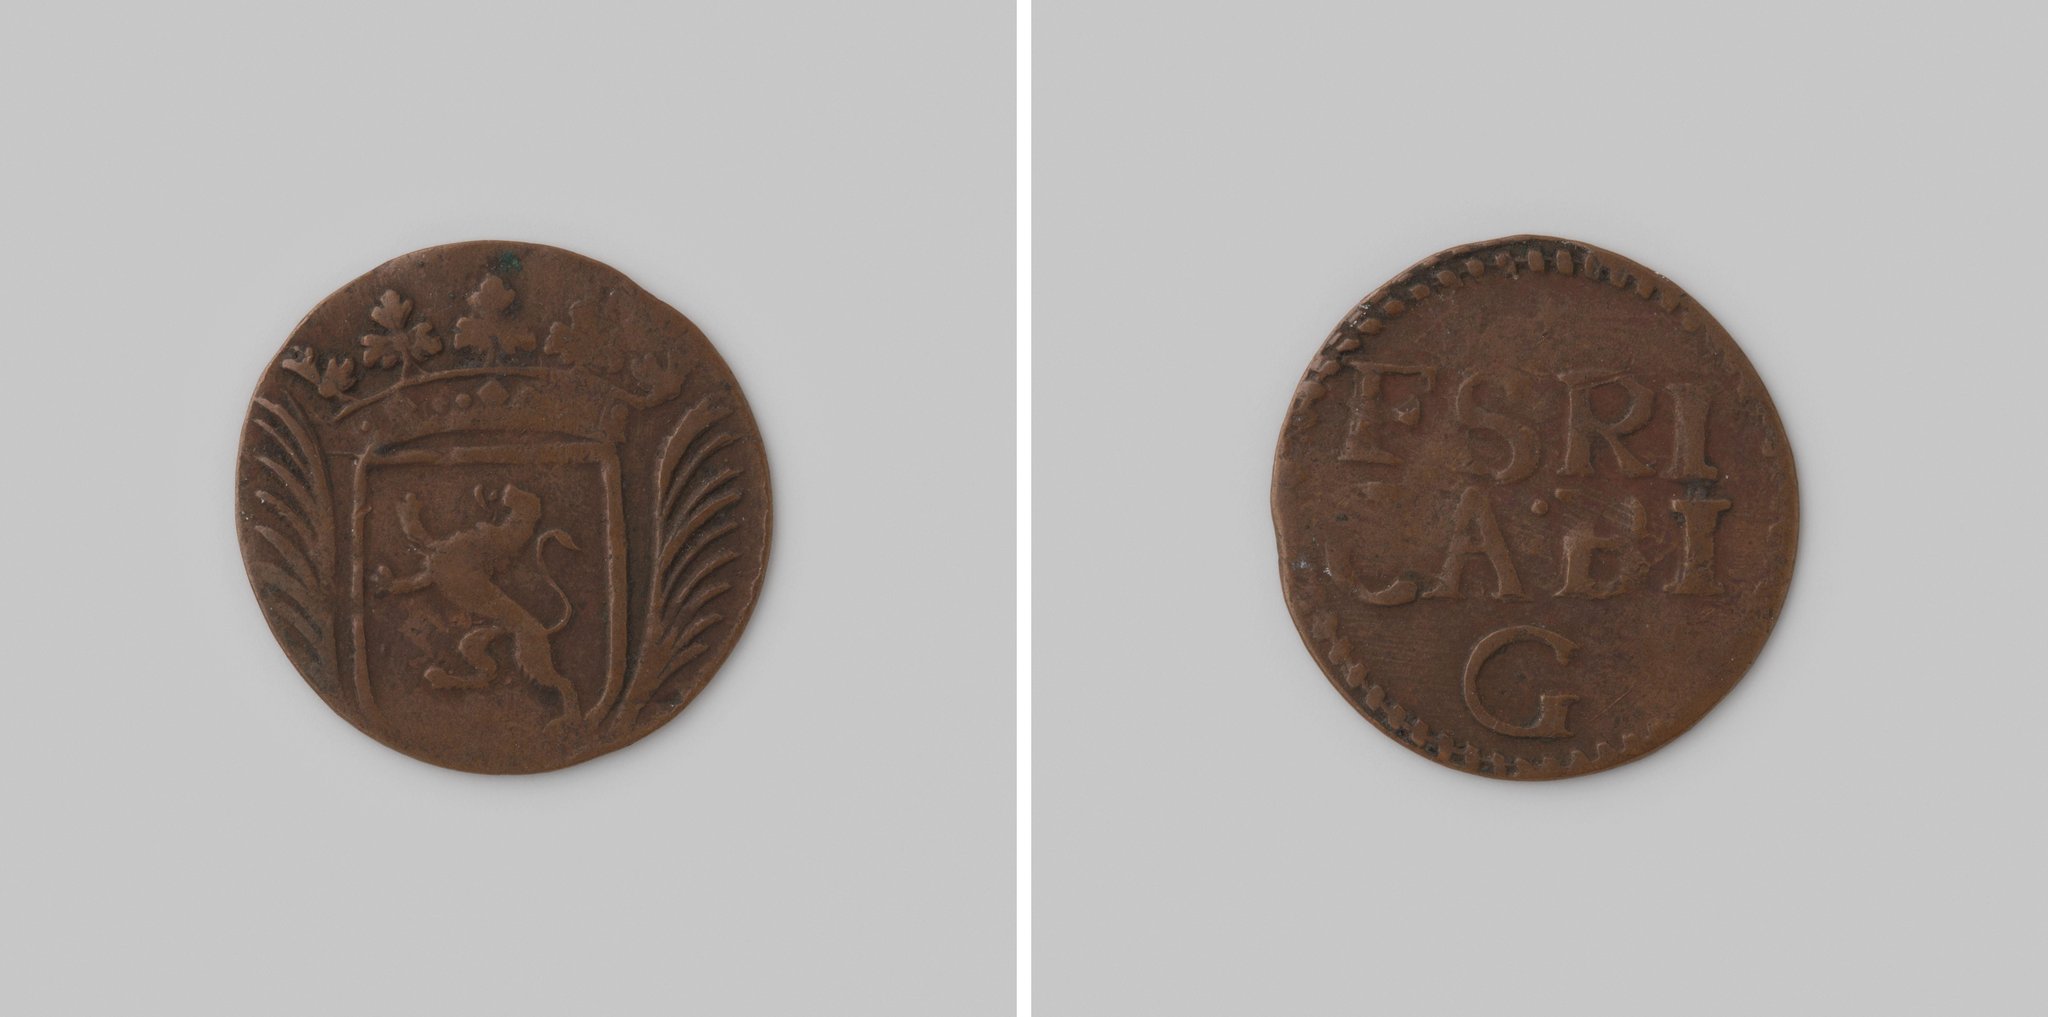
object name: coin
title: Gronsveldse duit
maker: joost maximiliaan van bronckhorst batenburg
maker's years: 1598-1662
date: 1617-1662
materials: copper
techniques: striking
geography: gronsveld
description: Voorzijde: tussen twee palmtakken gekroond wapenschild met klimmende leeuw naar links. Keerzijde: binnen parelcirkel opschrift FSRI/CABI/G in drie regels.